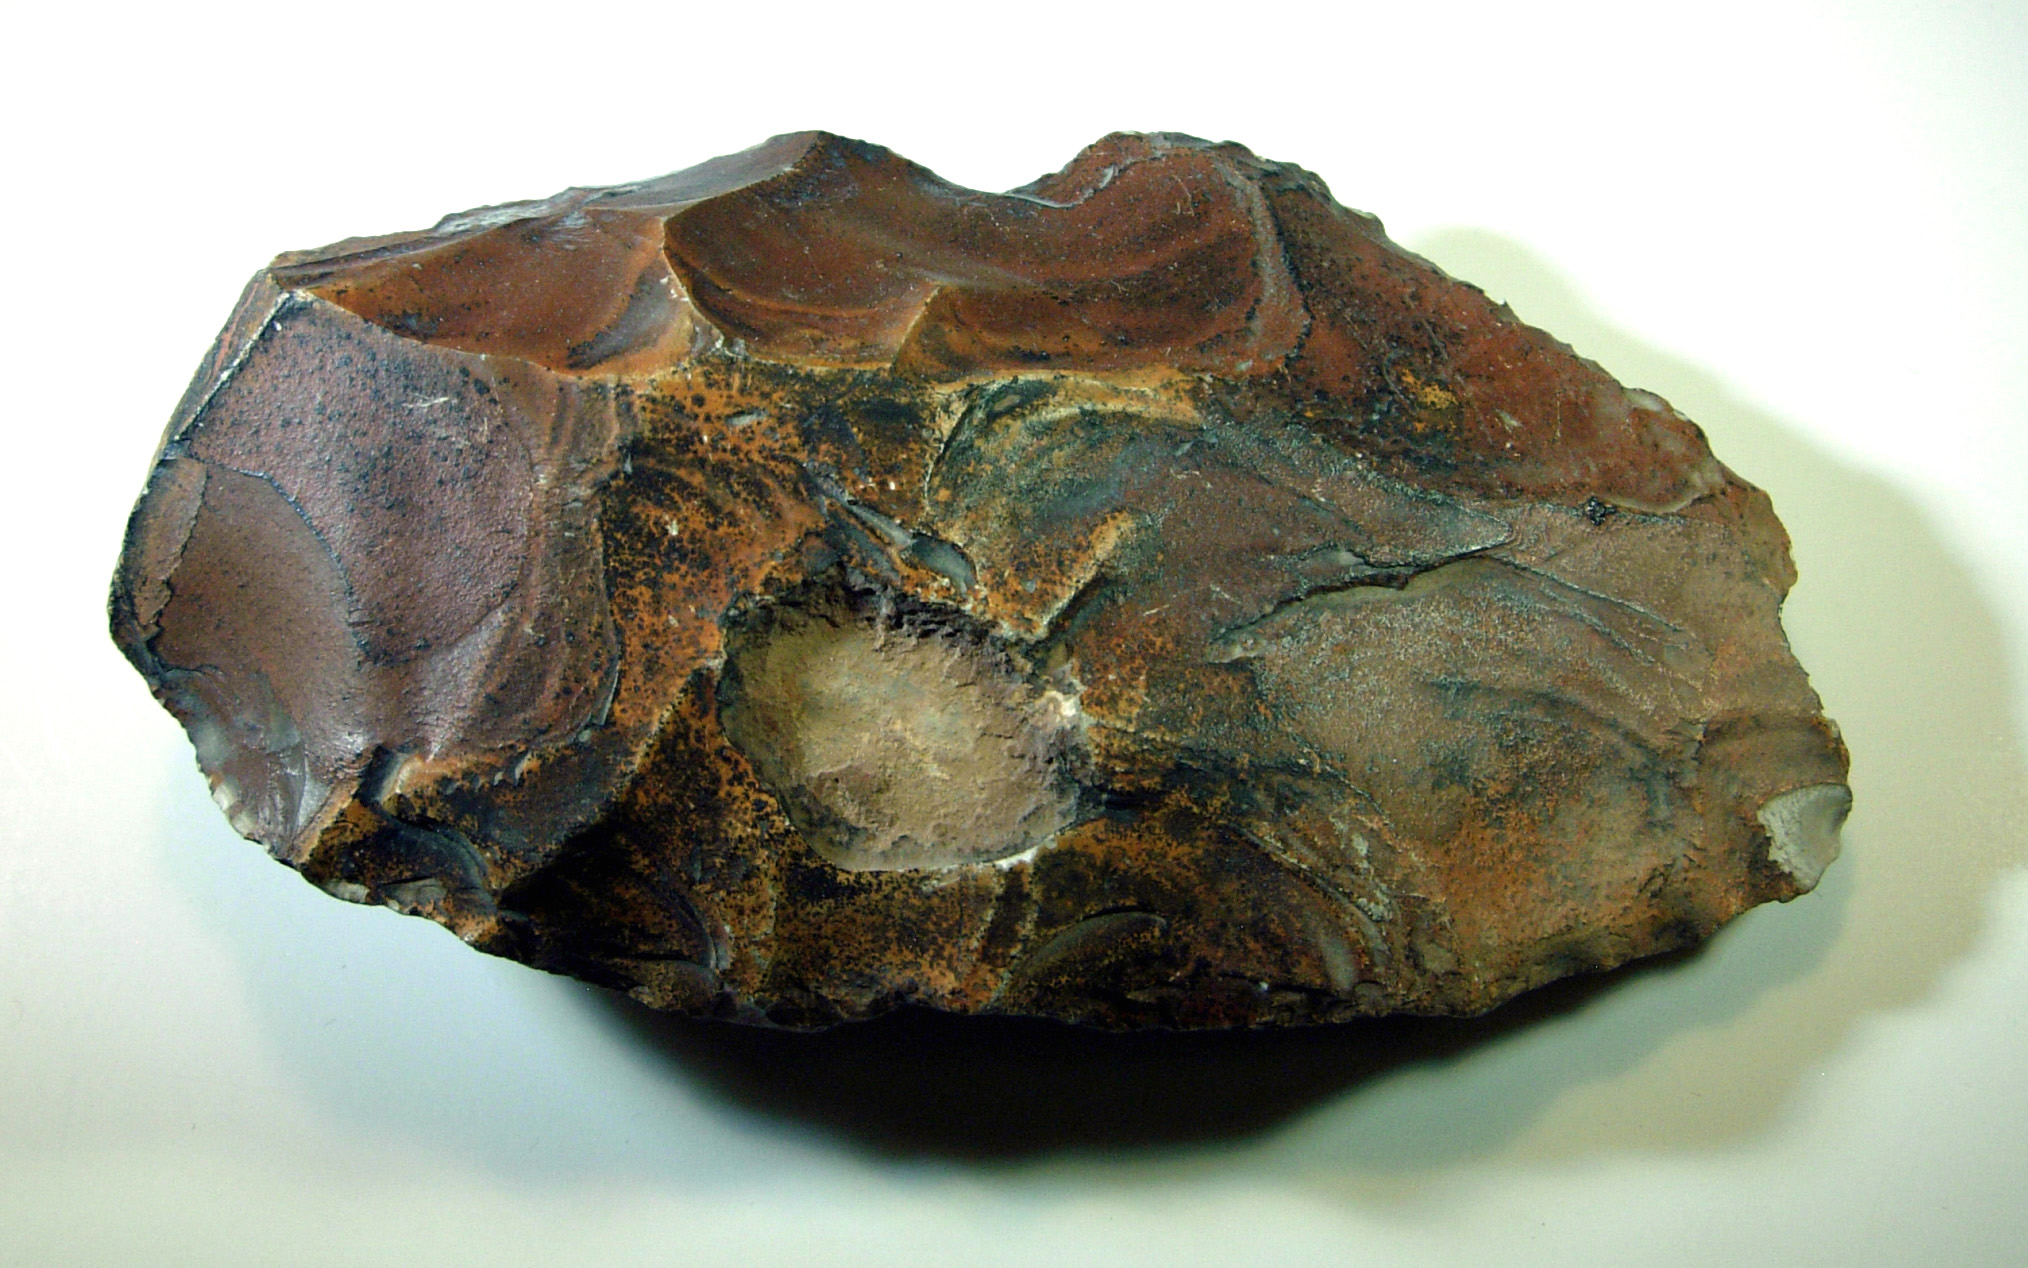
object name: tool, biface, hand ax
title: Biface, commonly referred to as a hand ax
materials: stone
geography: egypt